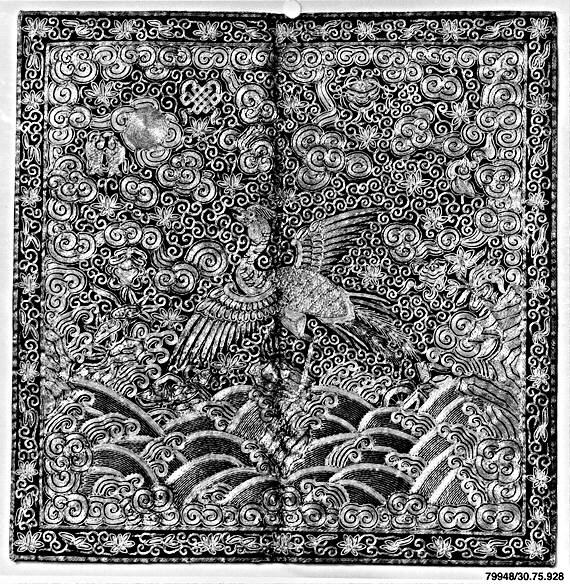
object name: rank badge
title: Rank Badge with Golden Pheasant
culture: chinese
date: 1701-1900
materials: metal thread, silk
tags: pheasants